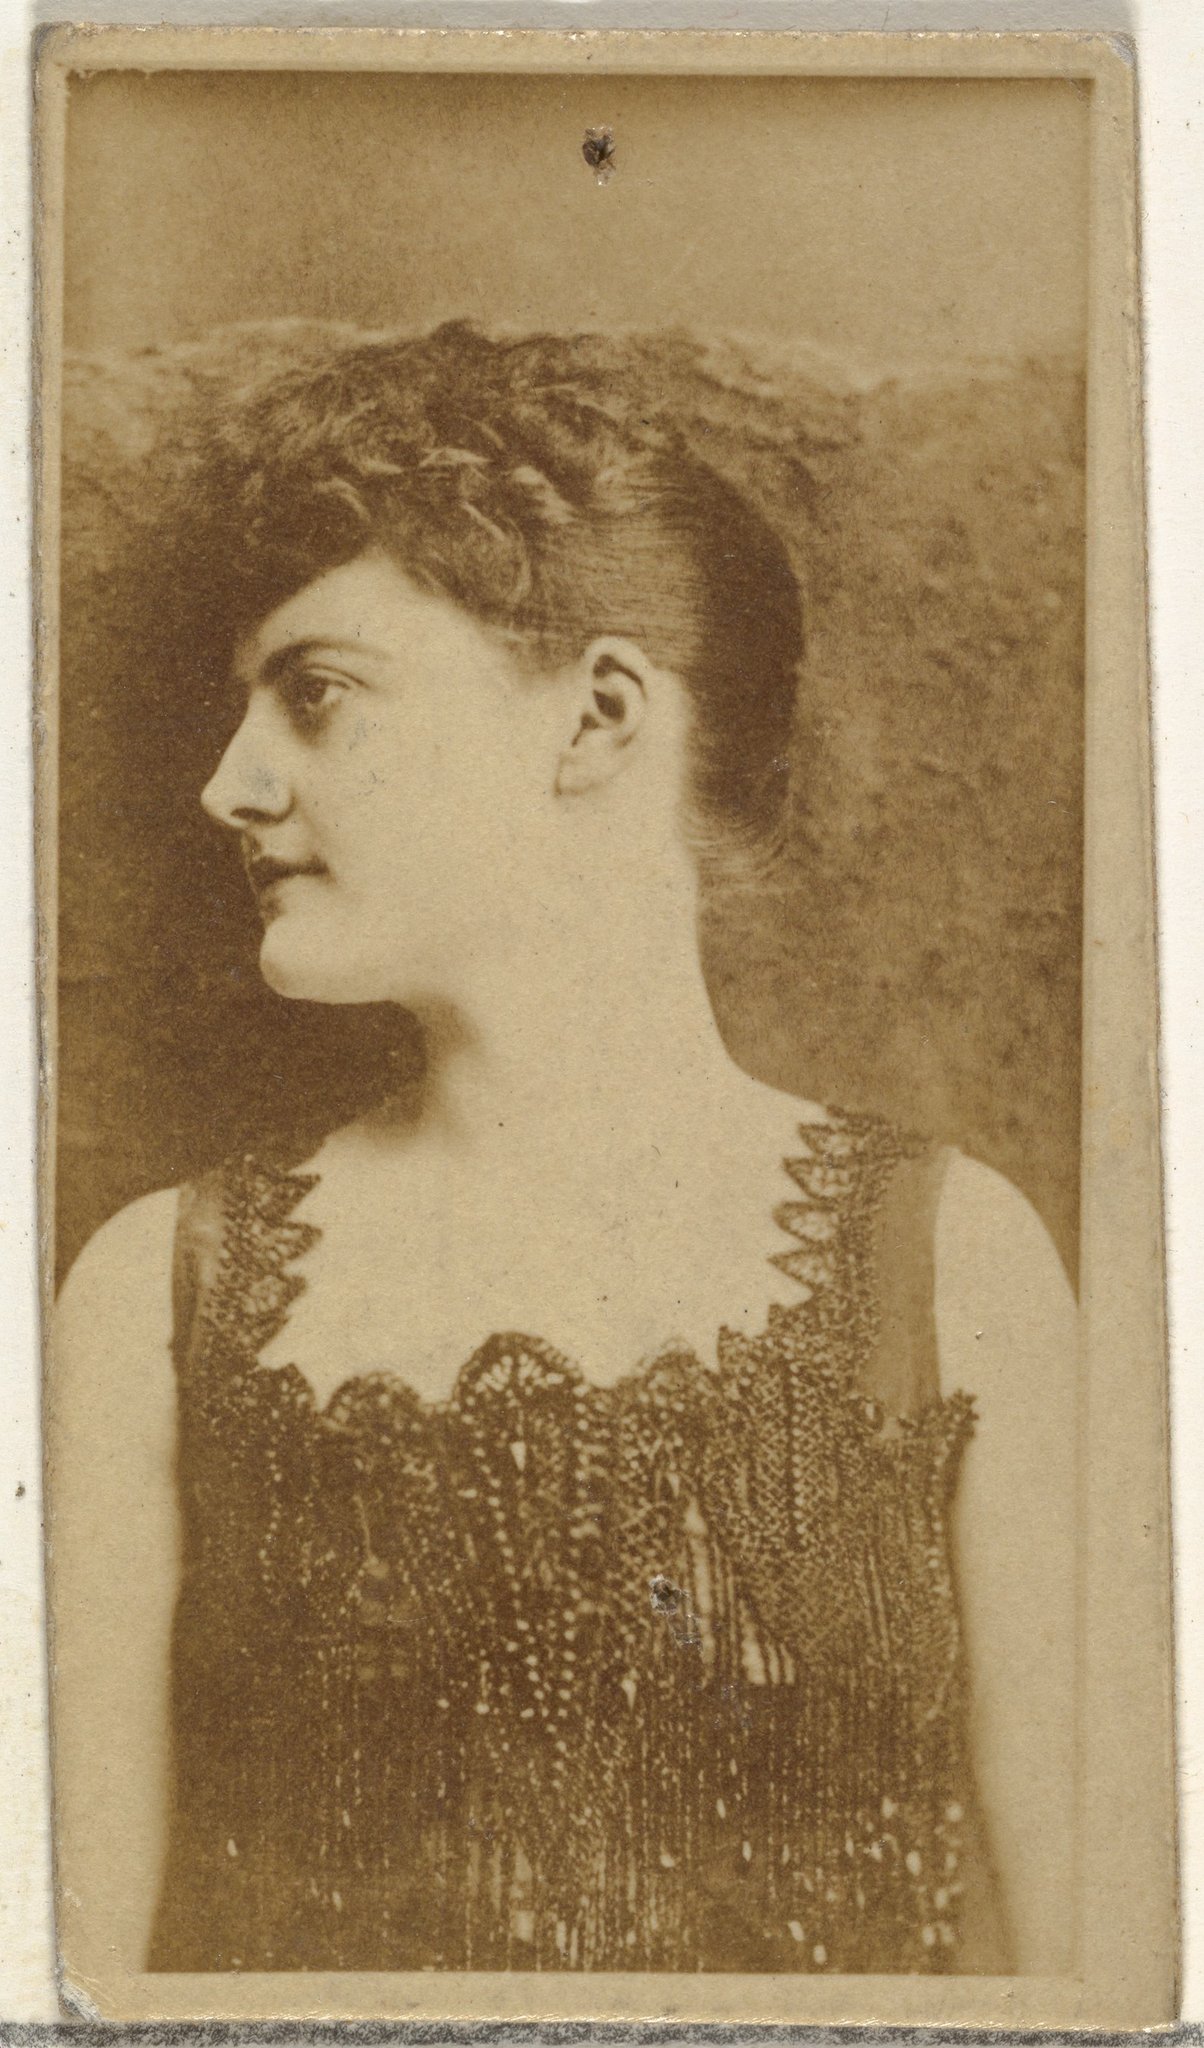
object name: photograph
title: [Actress in profile wearing ornate beaded gown], from the Actors and Actresses series (N145-8) issued by Duke Sons & Co. to promote Duke Cigarettes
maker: w. duke, sons & co.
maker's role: publisher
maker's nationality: american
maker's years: 1870-1920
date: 1891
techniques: albumen silver print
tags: women,actresses